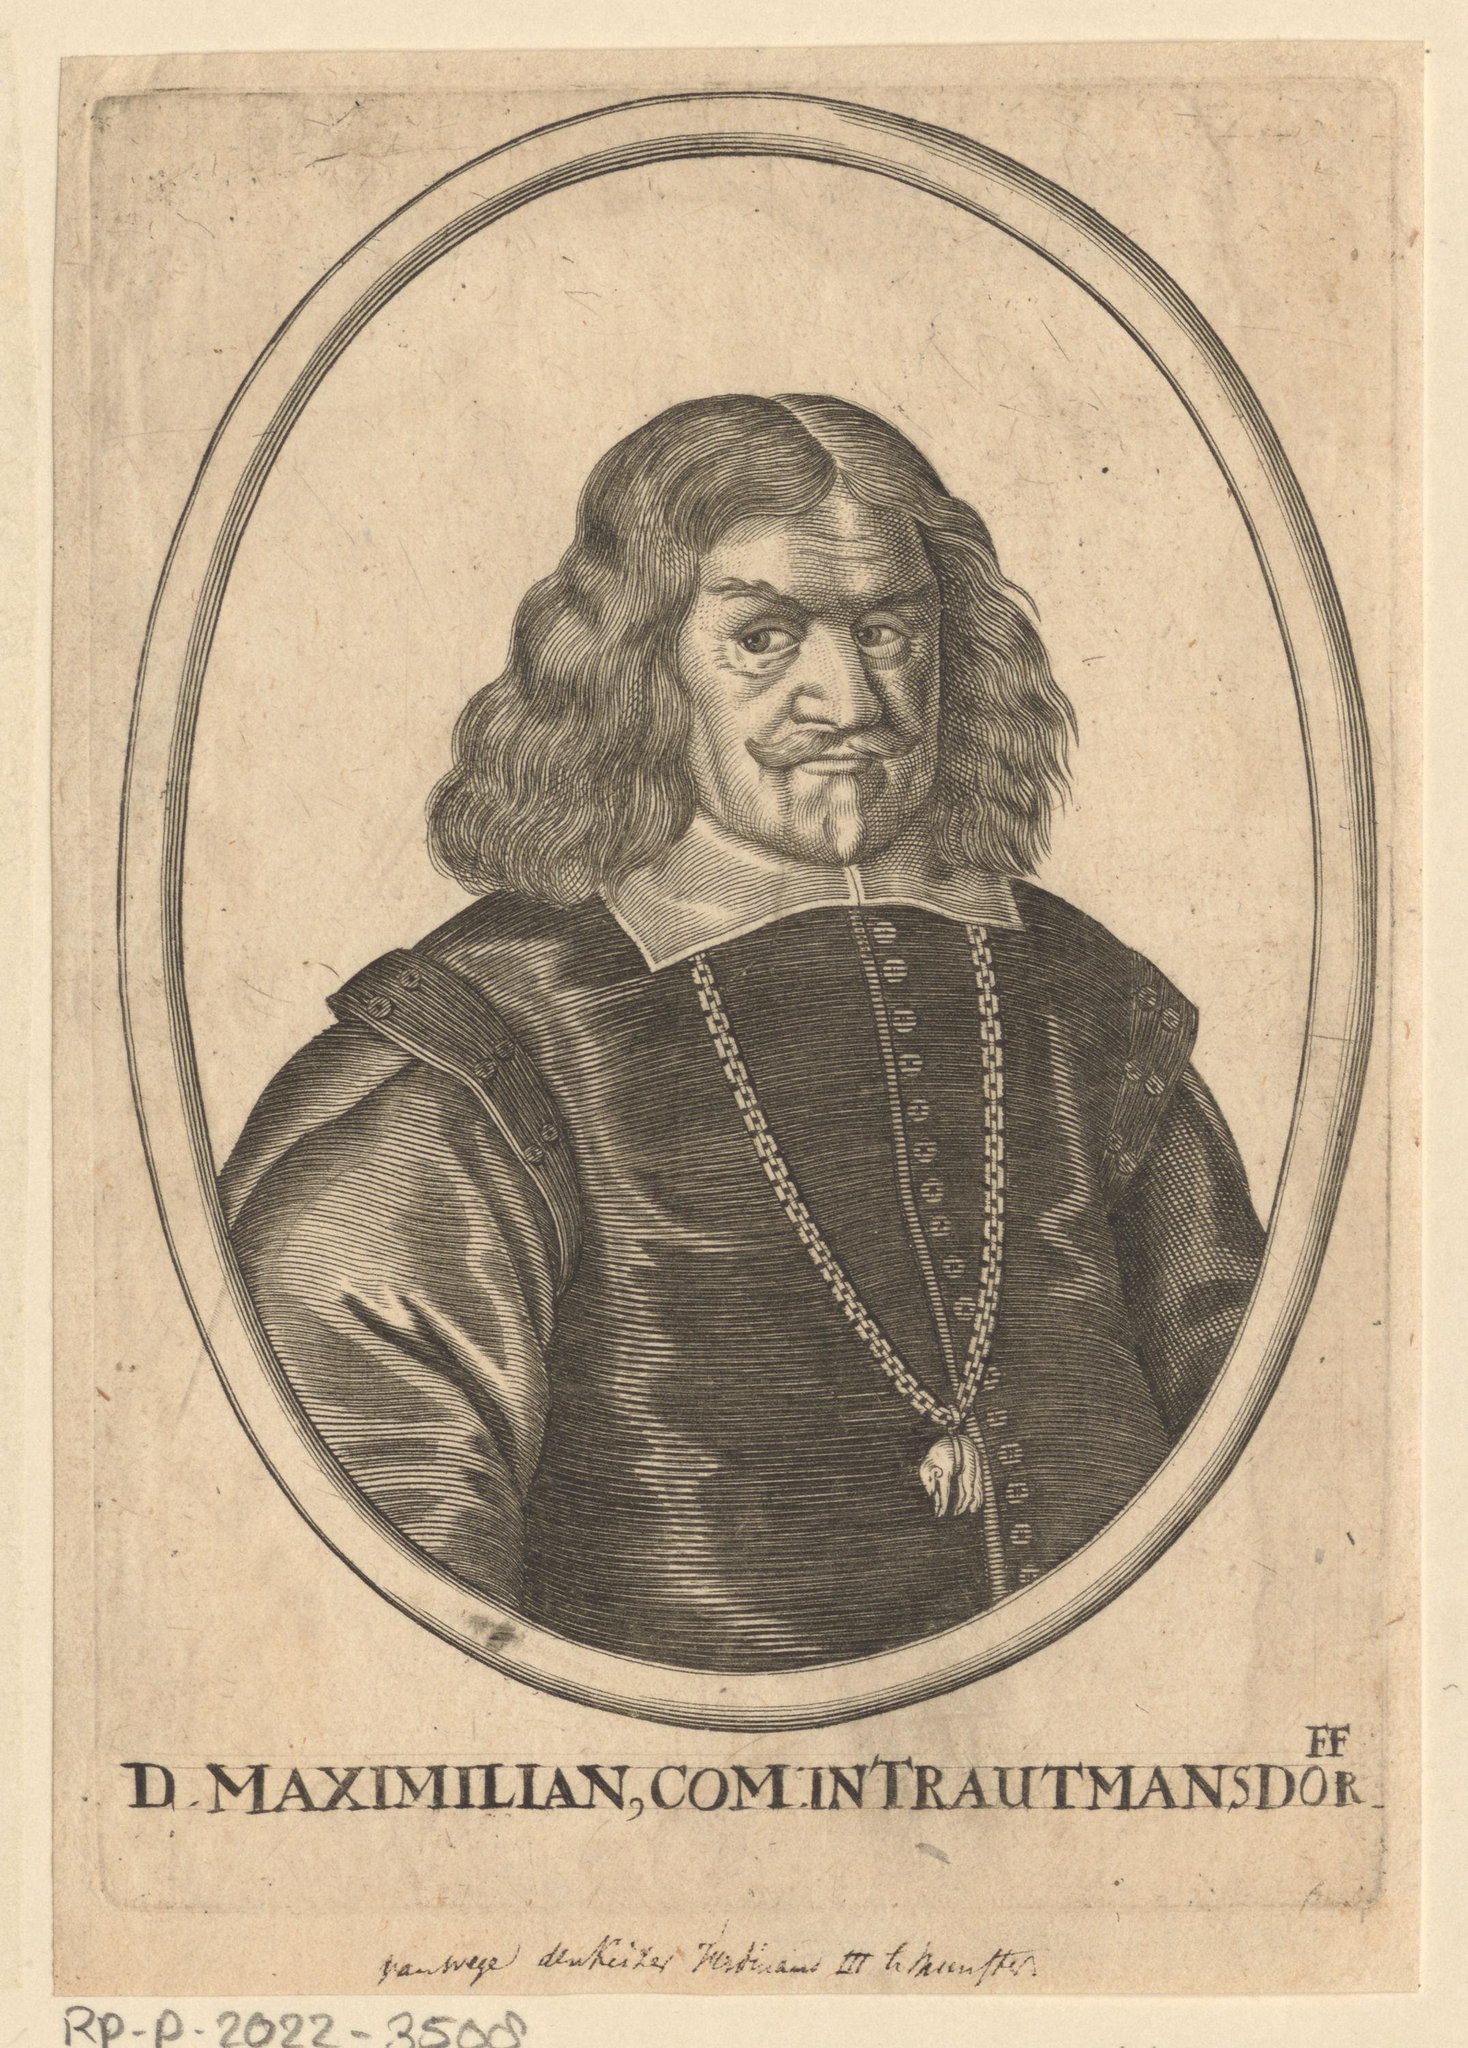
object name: print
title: Portret van Maximilian von Trauttmansdorff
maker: Anonymous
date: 1648-1686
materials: paper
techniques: engraving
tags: vienna, historical persons, knighthood order of the golden fleece, diplomacy, diplomat